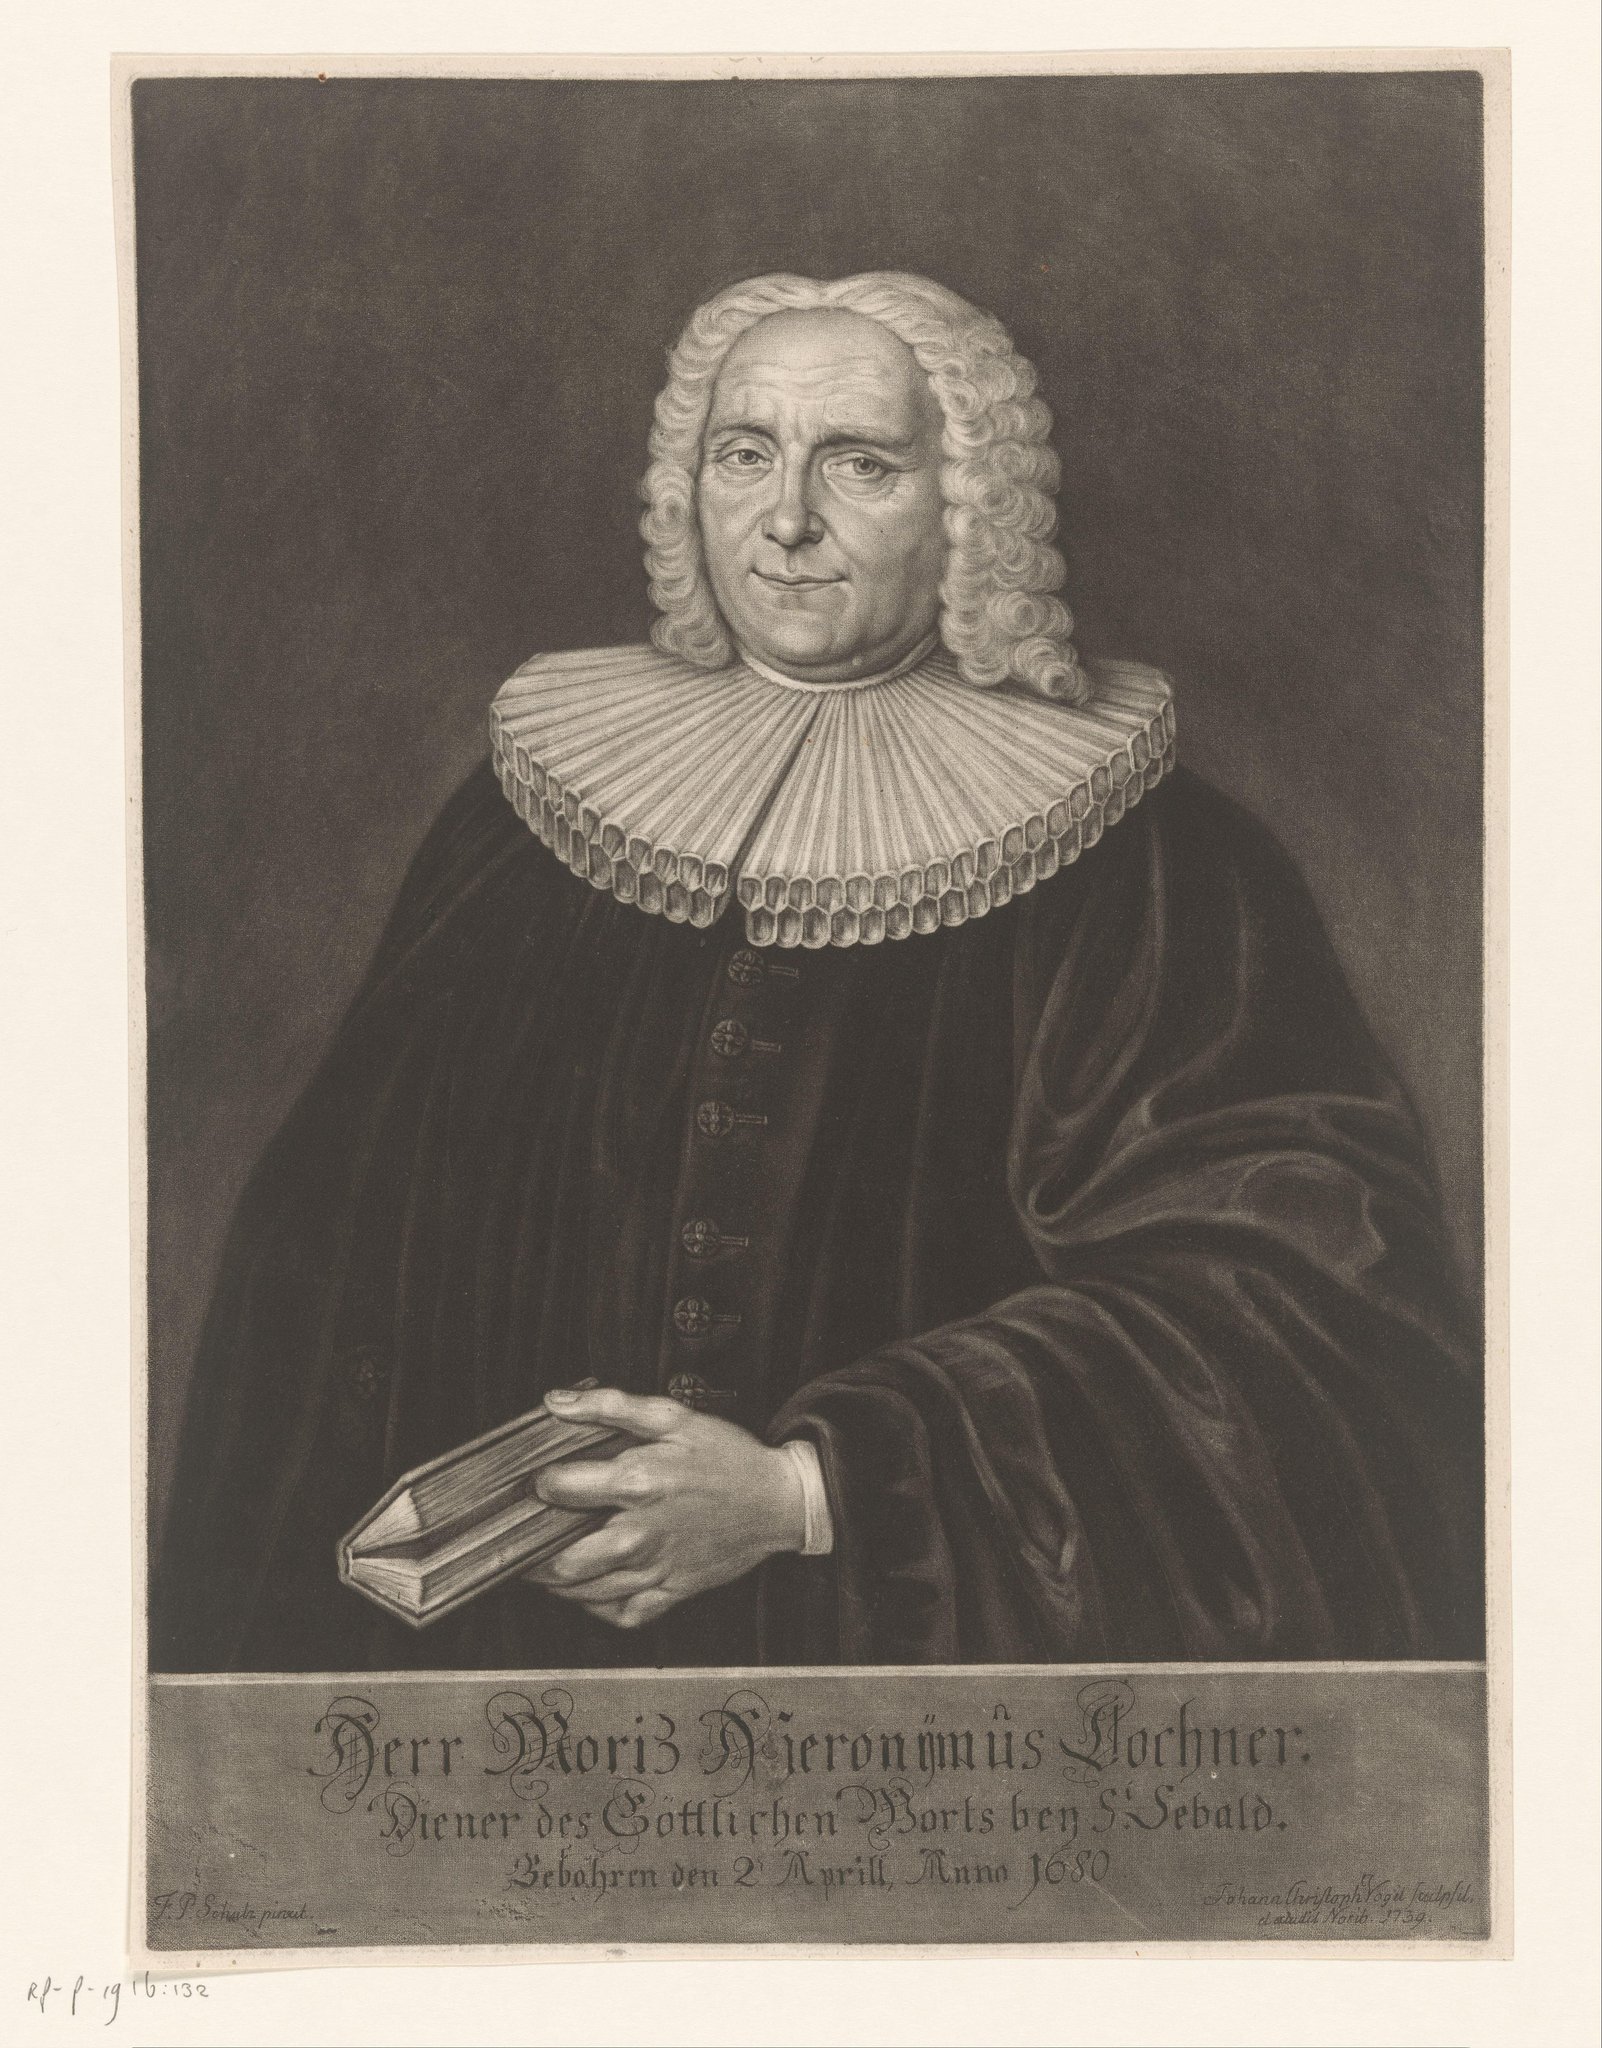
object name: print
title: Portret van Moritz Hieronymus Lochner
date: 1739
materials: paper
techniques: mezzotint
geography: nuremberg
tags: historical persons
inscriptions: collector's mark: Lugt 2228